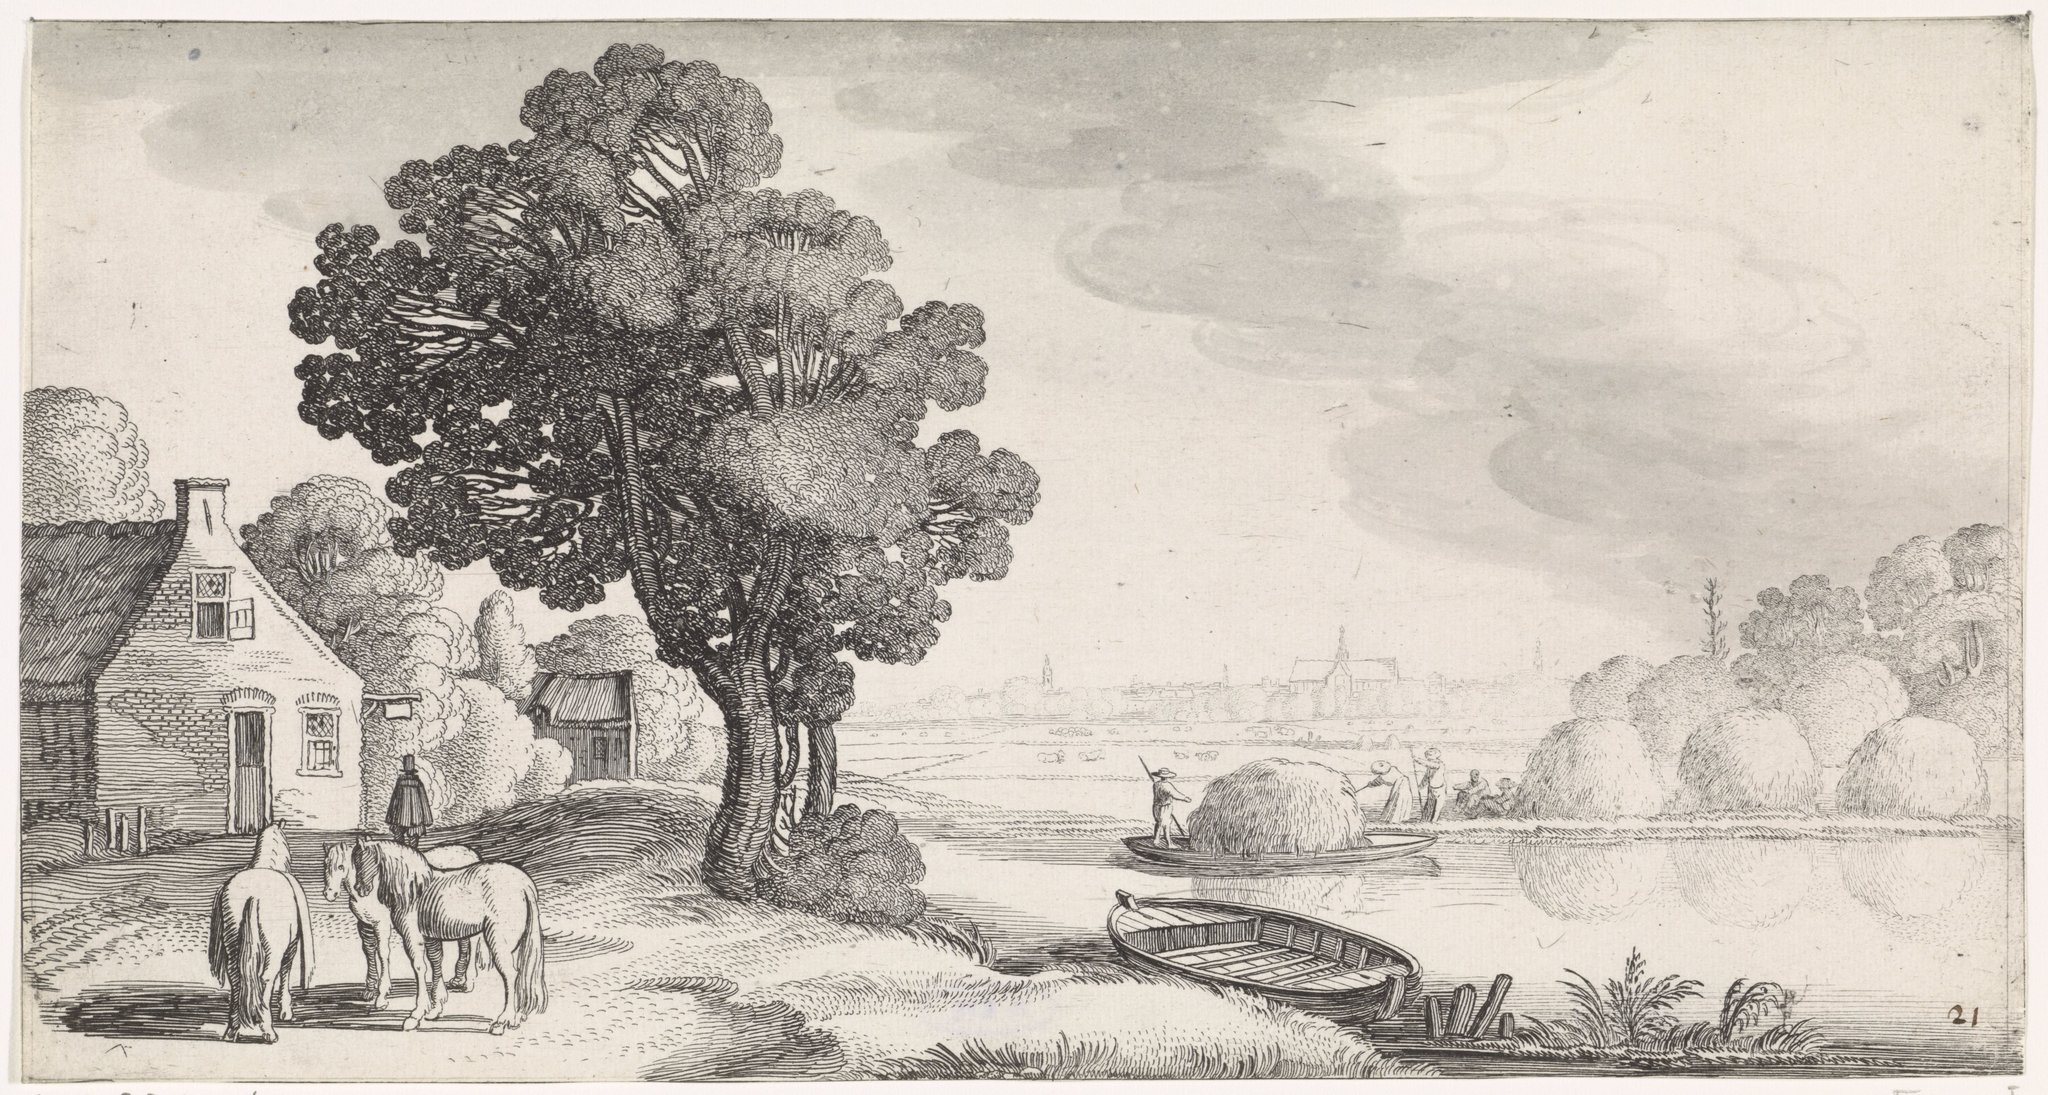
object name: print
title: Transport van hooi op een rivier met Haarlem in de verte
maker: jan van de velde (ii)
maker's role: draughtsman, painter, print maker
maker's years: 1593-1641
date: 1639-1641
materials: ink, paper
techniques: brush, etching, pen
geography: northern netherlands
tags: agricultural products and by-products: hay, river, transporting ~ harvest, horse, hay-stack, haarlem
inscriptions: number: ‘21’, collector's mark: Lugt 2228, collector's mark: Lugt 1120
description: Transport van hooi op een rivier. Op het water een hooischuit en aan de oever figuren bij drie hooibergen. Links een huis en een figuur en drie paarden op een pad. Aan de horizon Haarlem met onder andere de Sint-Bavokerk. Eenentwintigste prent van een serie met 36 prenten van landschappen, verdeeld over zes delen.